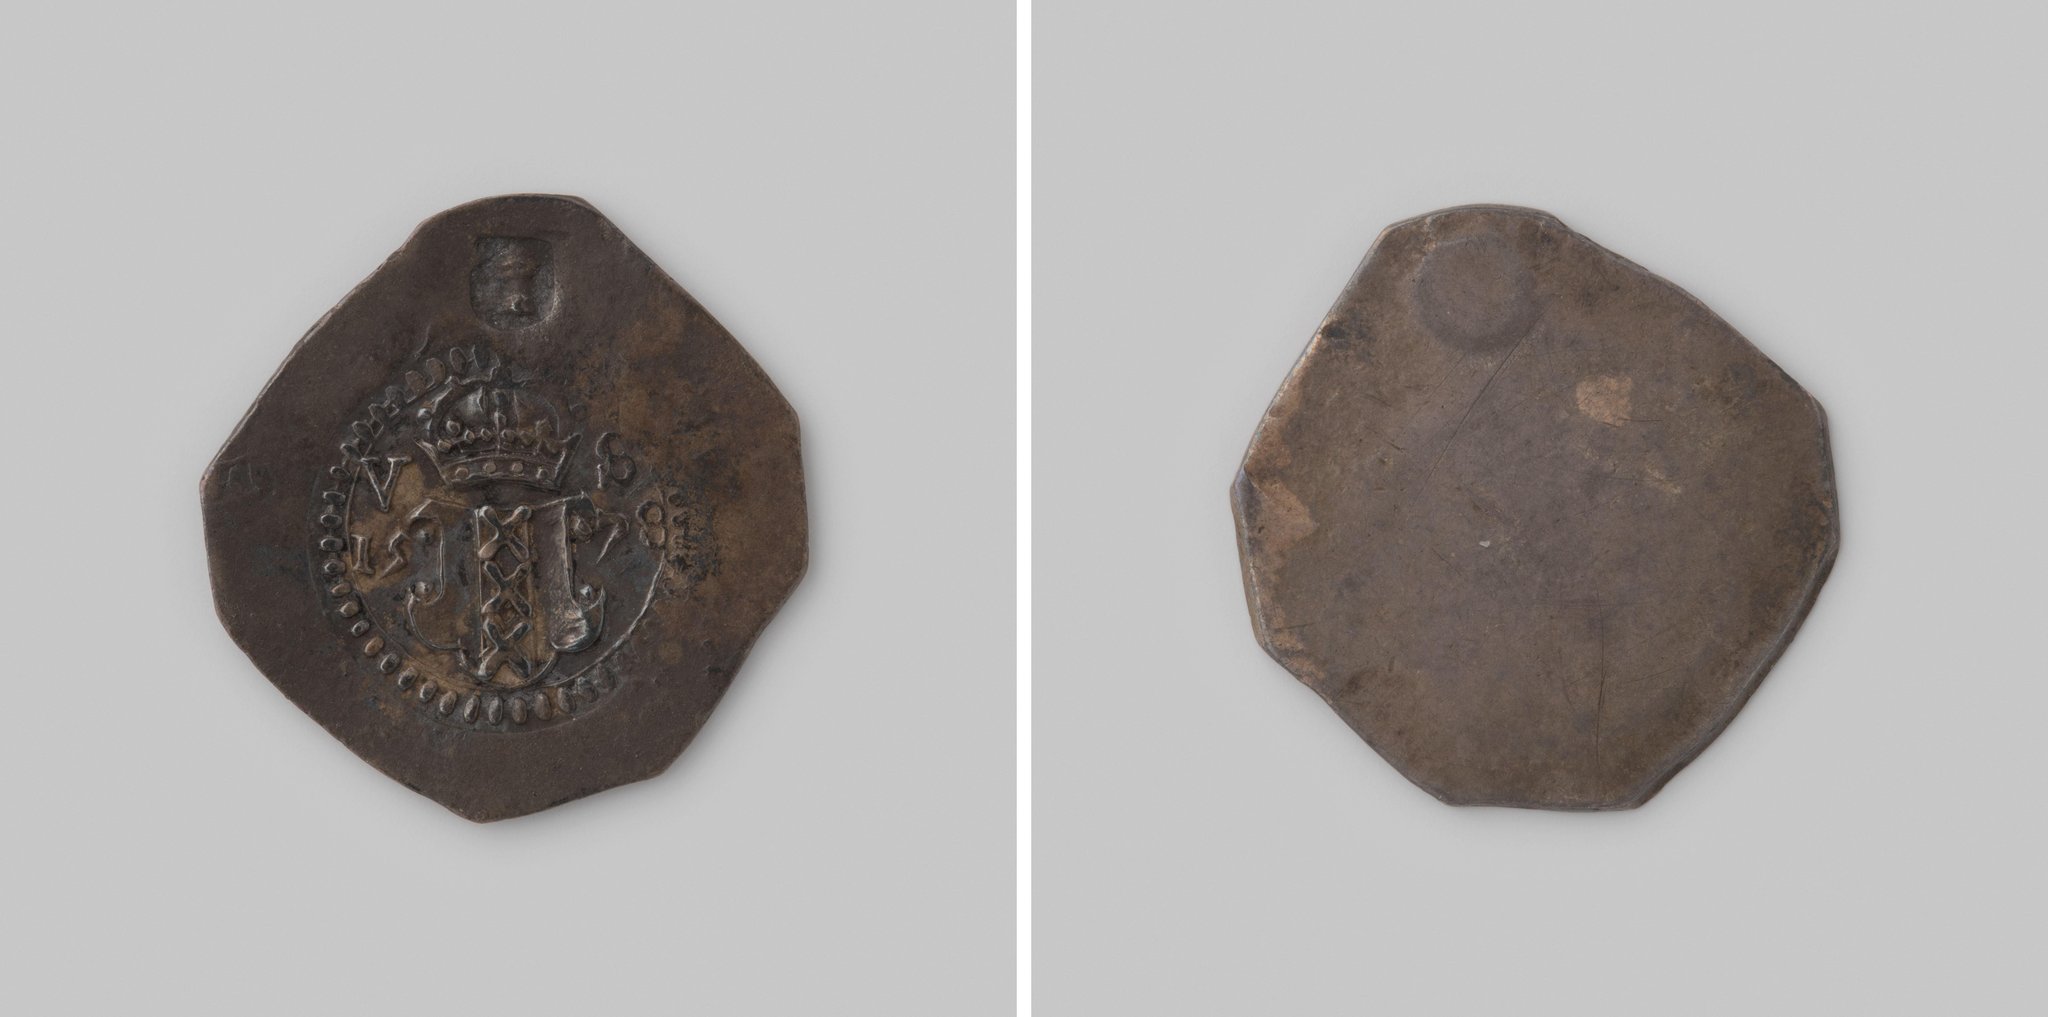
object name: siege coin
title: Vijf stuiver, noodmunt uit Amsterdam, geslagen tijdens het beleg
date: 1578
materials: silver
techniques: striking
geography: amsterdam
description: Zilveren noodmunt van Amsterdam. Voorzijde: twee stempels, in het midden binnen parelrand tussen waarde-aanduiding en jaartal gekroond wapenschild van Amsterdam, bovenaan meesterteken soldeervaas. Keerzijde: blank. Noodmunt op zilveren min of meer vierkante plaat.